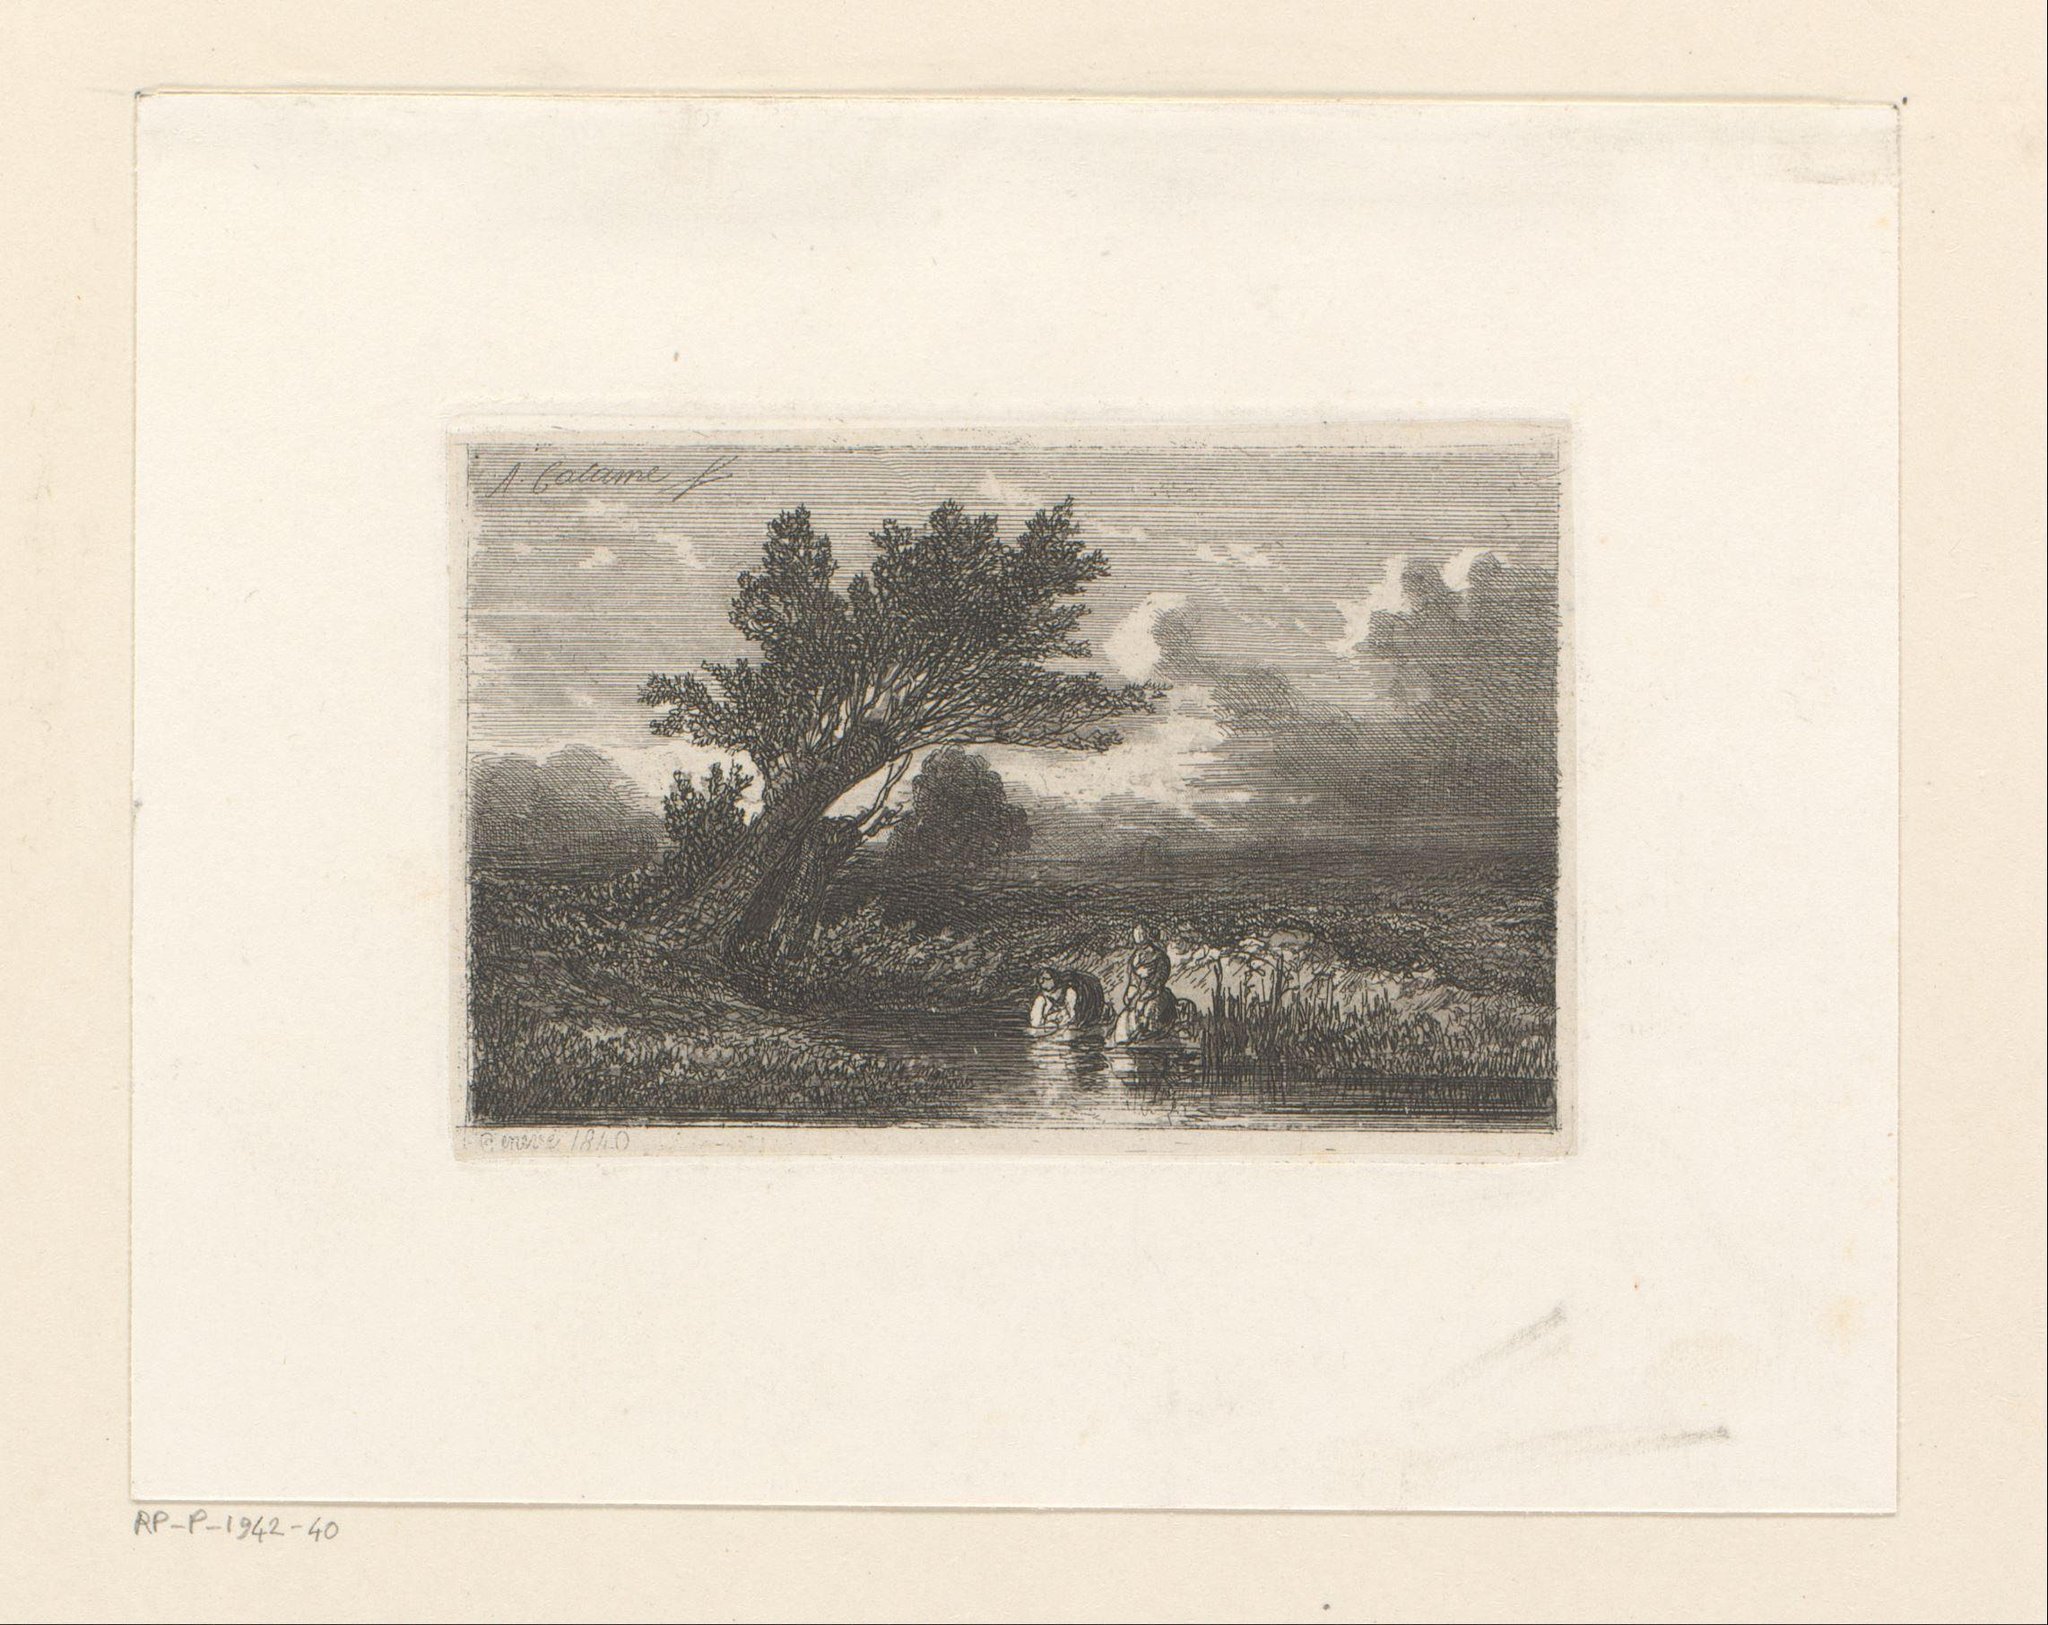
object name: print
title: Essais de gravure a l'eau forte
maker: alexandre calame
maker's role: draughtsman, painter, print maker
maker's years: 1810-1864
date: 1840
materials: paper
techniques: etching, roulette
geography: geneva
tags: trees: willow, landscapes (+ landscape with figures, staffage)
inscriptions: collector's mark: Lugt 2760, collector's mark: Lugt 2228